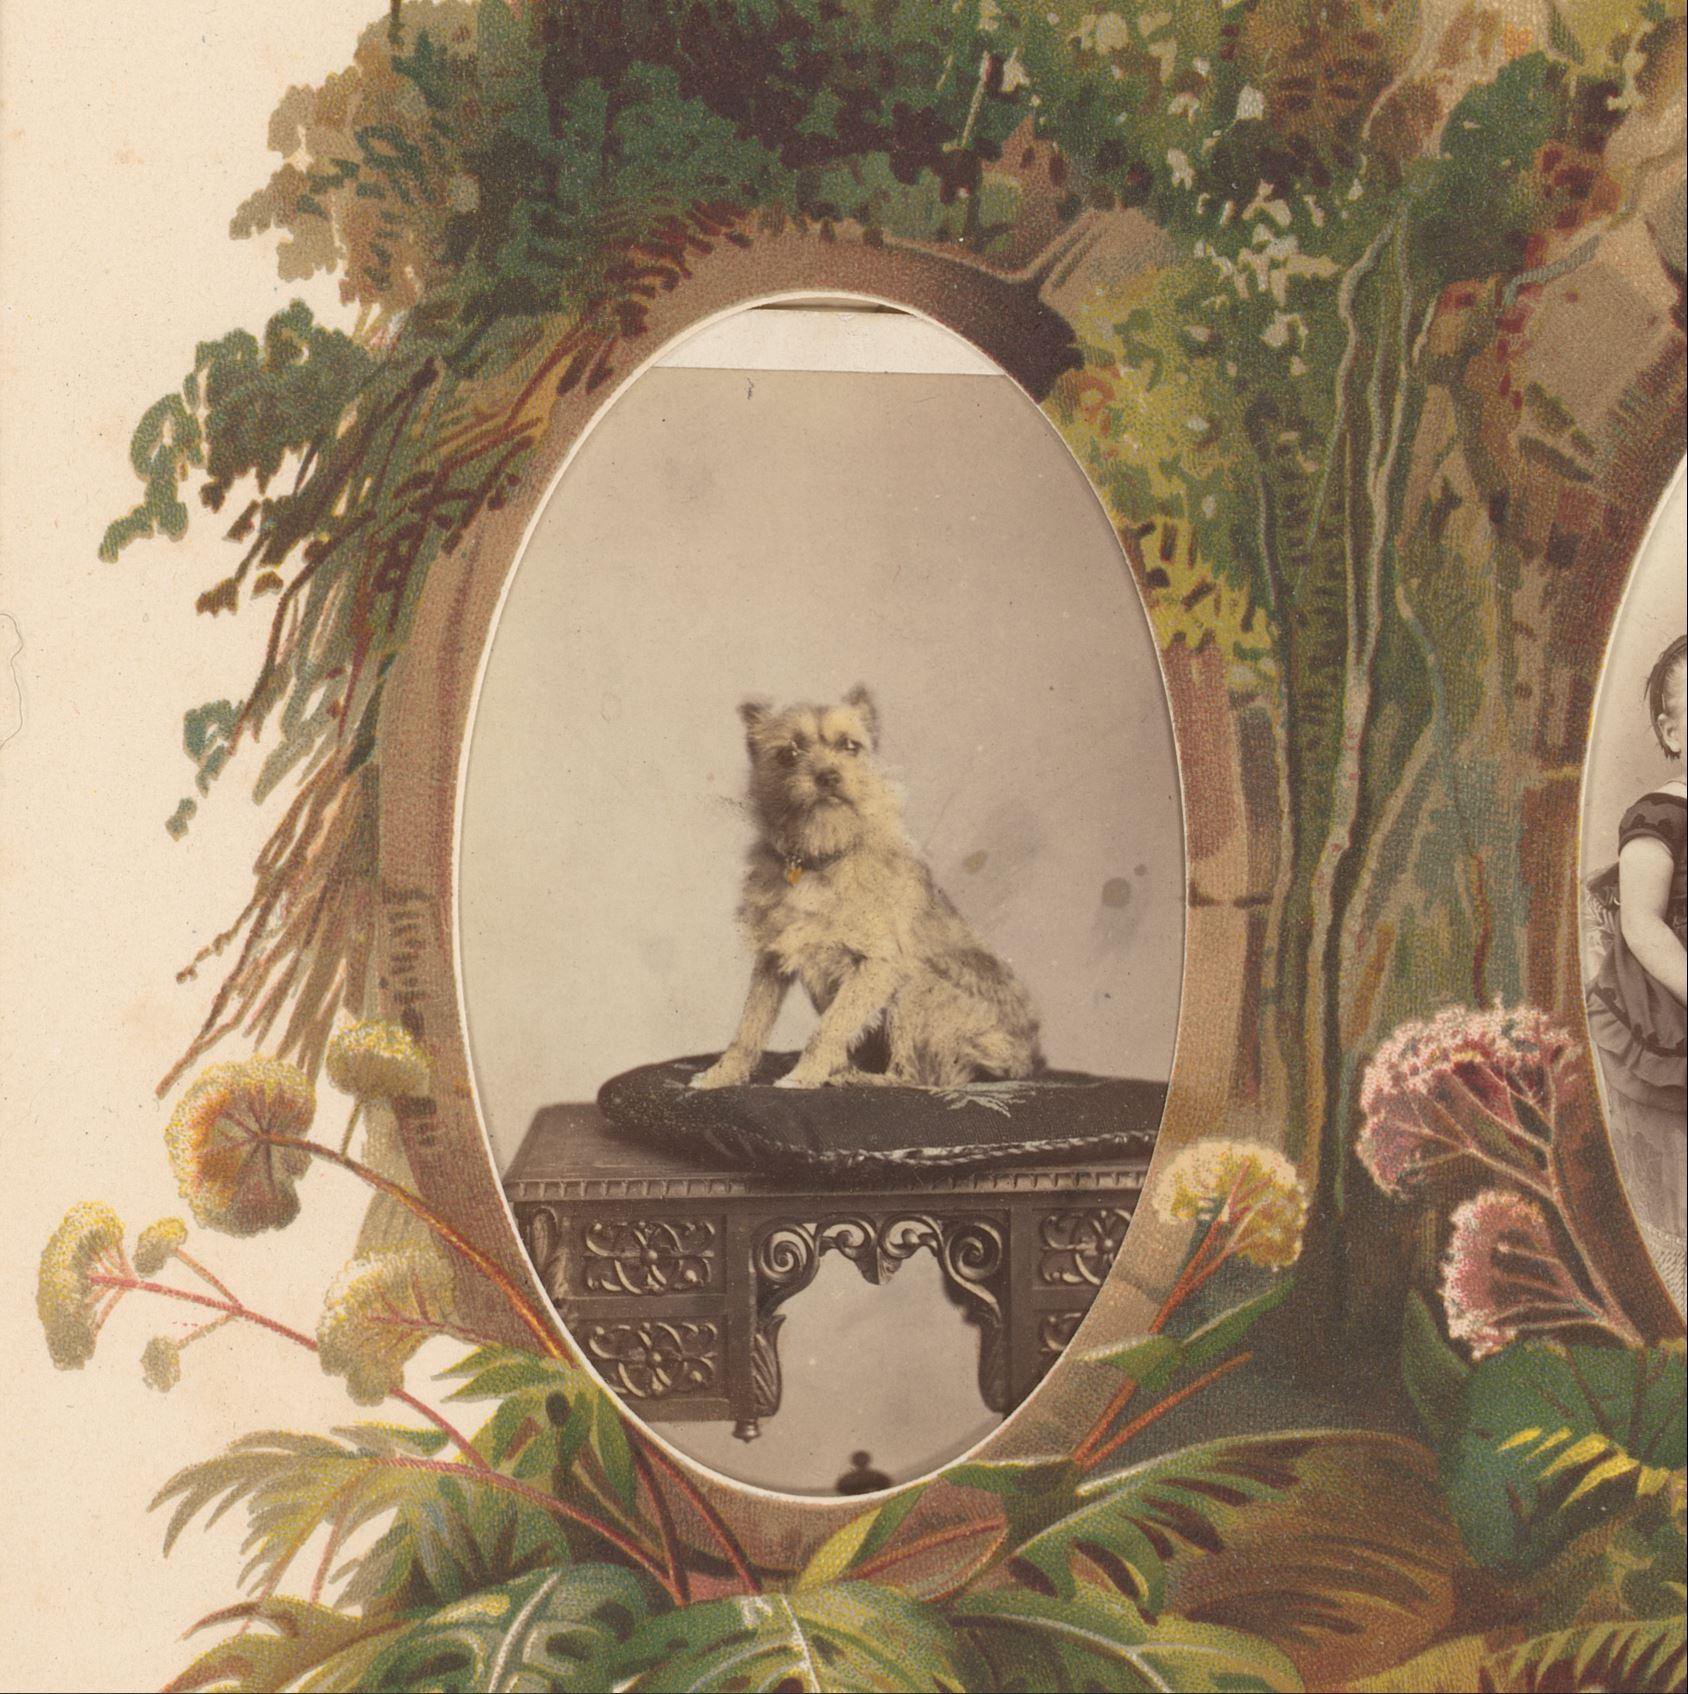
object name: photograph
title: Hond op een kussen op een geornamenteerde tafel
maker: louis oskar grienwaldt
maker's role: fotograaf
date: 1862-1867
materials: cardboard, photographic support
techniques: albumen print, hand coloring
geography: bremen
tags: table, dog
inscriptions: annotation: ‘Max/ [...] v. herr Hoffmann/ [..] der jung [...]/ [...]’, inscription: ‘L. O. GRIENWALDT'S/ Photographisches Institut/ Wall No. 86./ BREMEN./ Die Original-Platte ist zum Nachbestellen/ aufbewahrt.’